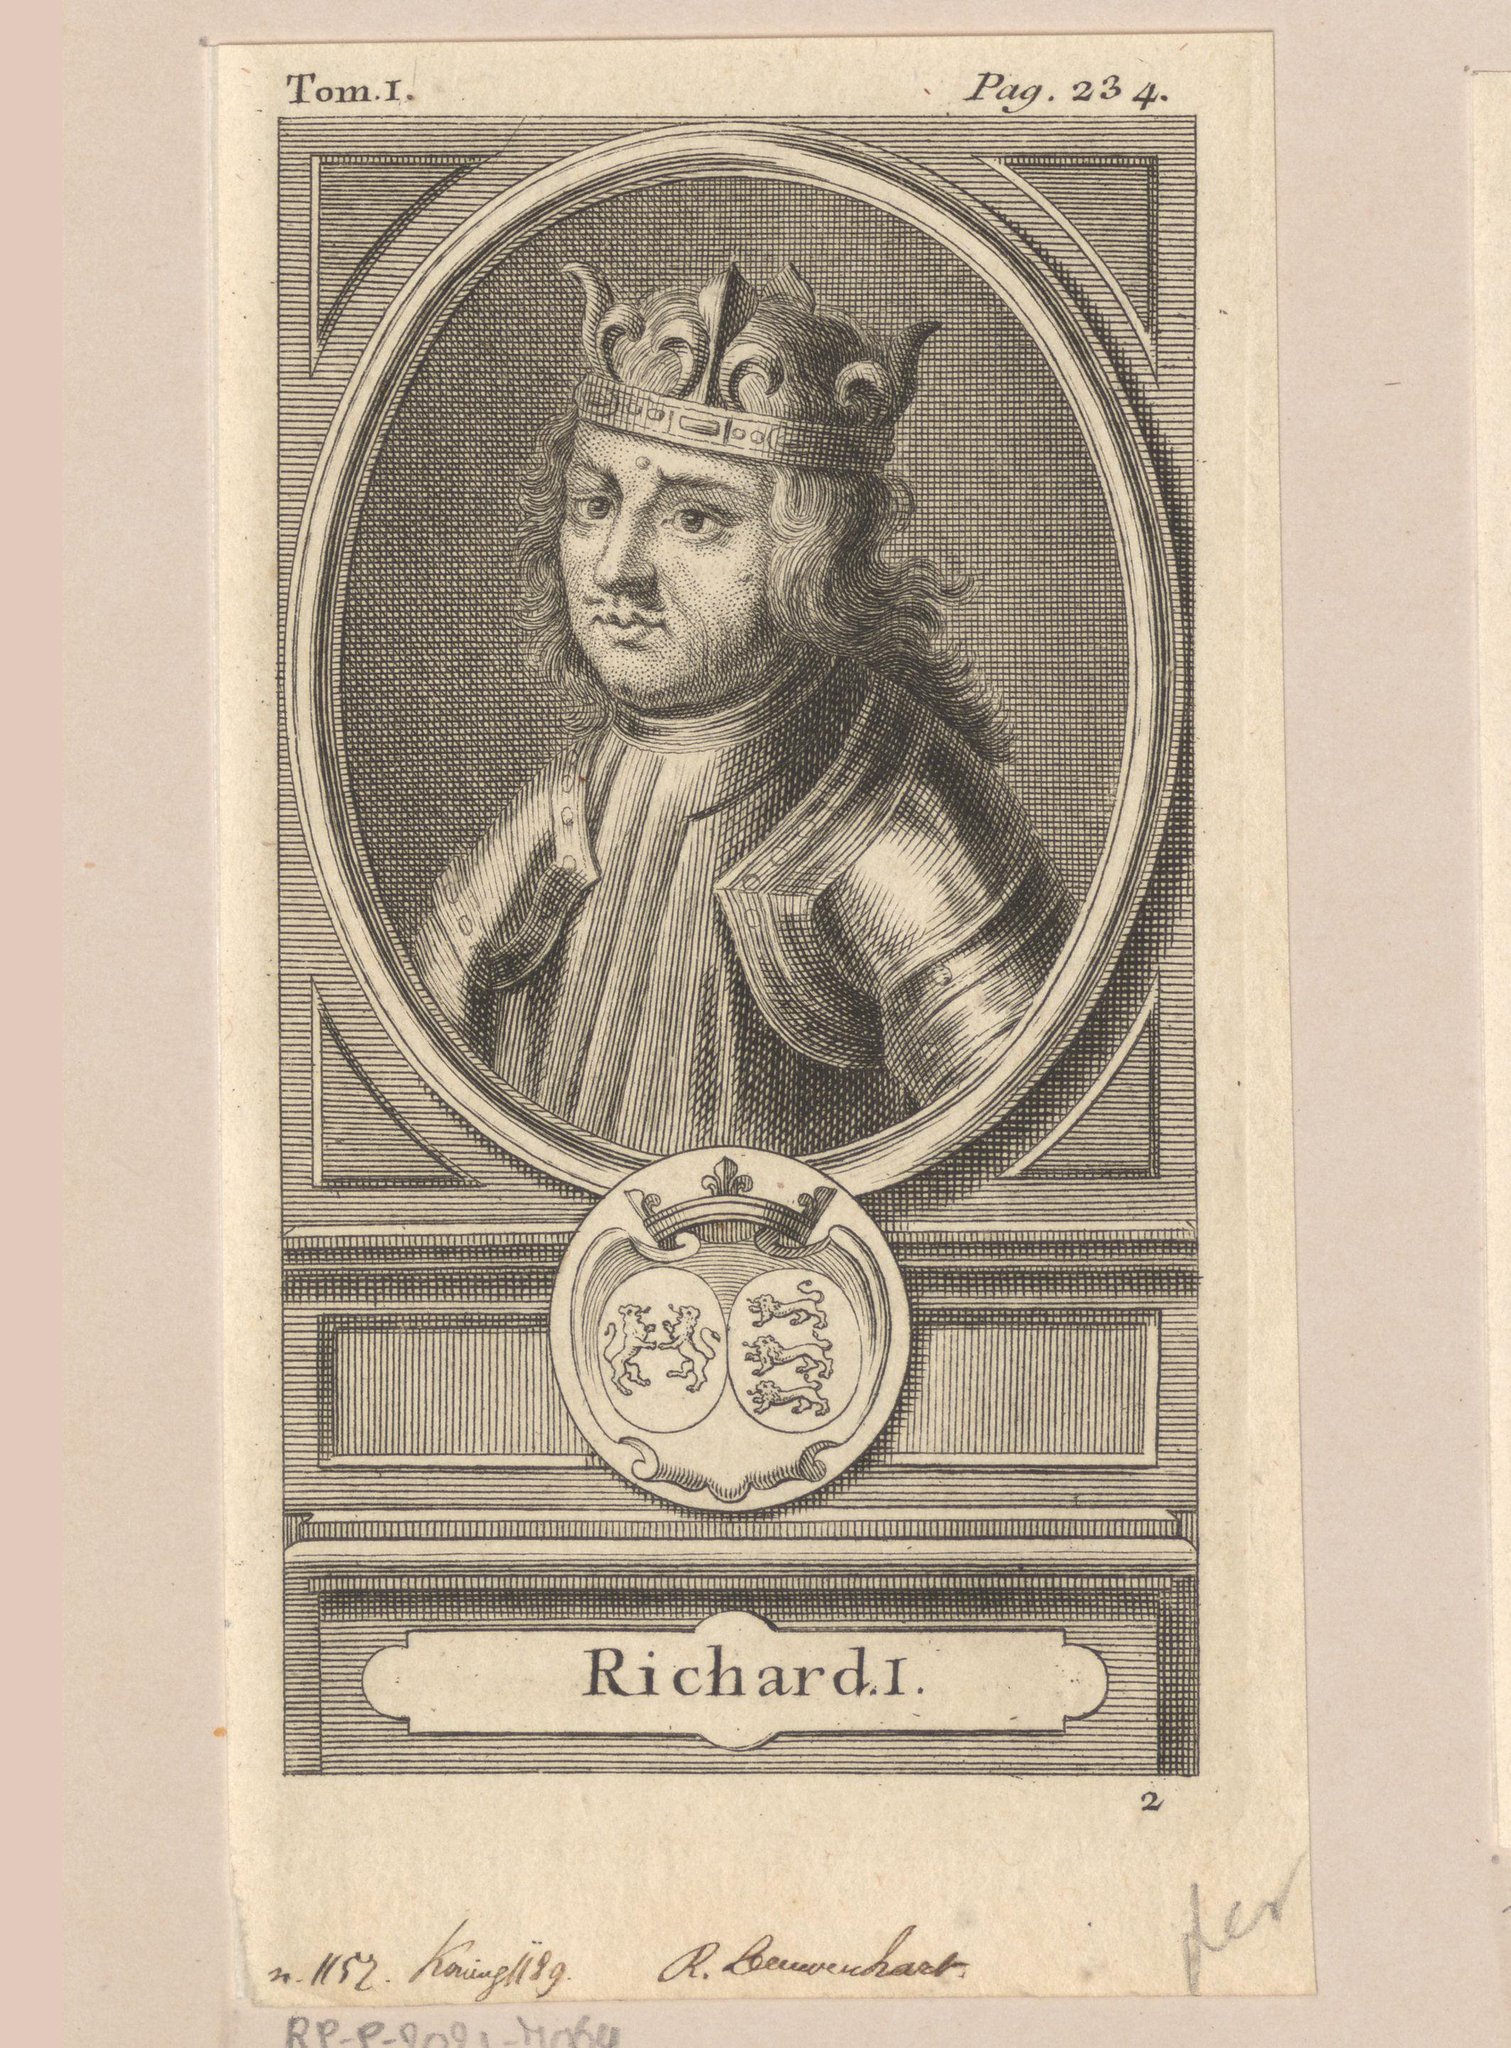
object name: print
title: Portret van Richard I Leeuwenhart, koning van Engeland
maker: Anonymous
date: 1740-1769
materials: paper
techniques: engraving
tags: historical persons, king, armorial bearing, heraldry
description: Bovenaan genummerd: Tom. I. Pag. 234, rechtsonder genummerd: 2. Onder het portret zijn wapenschild.